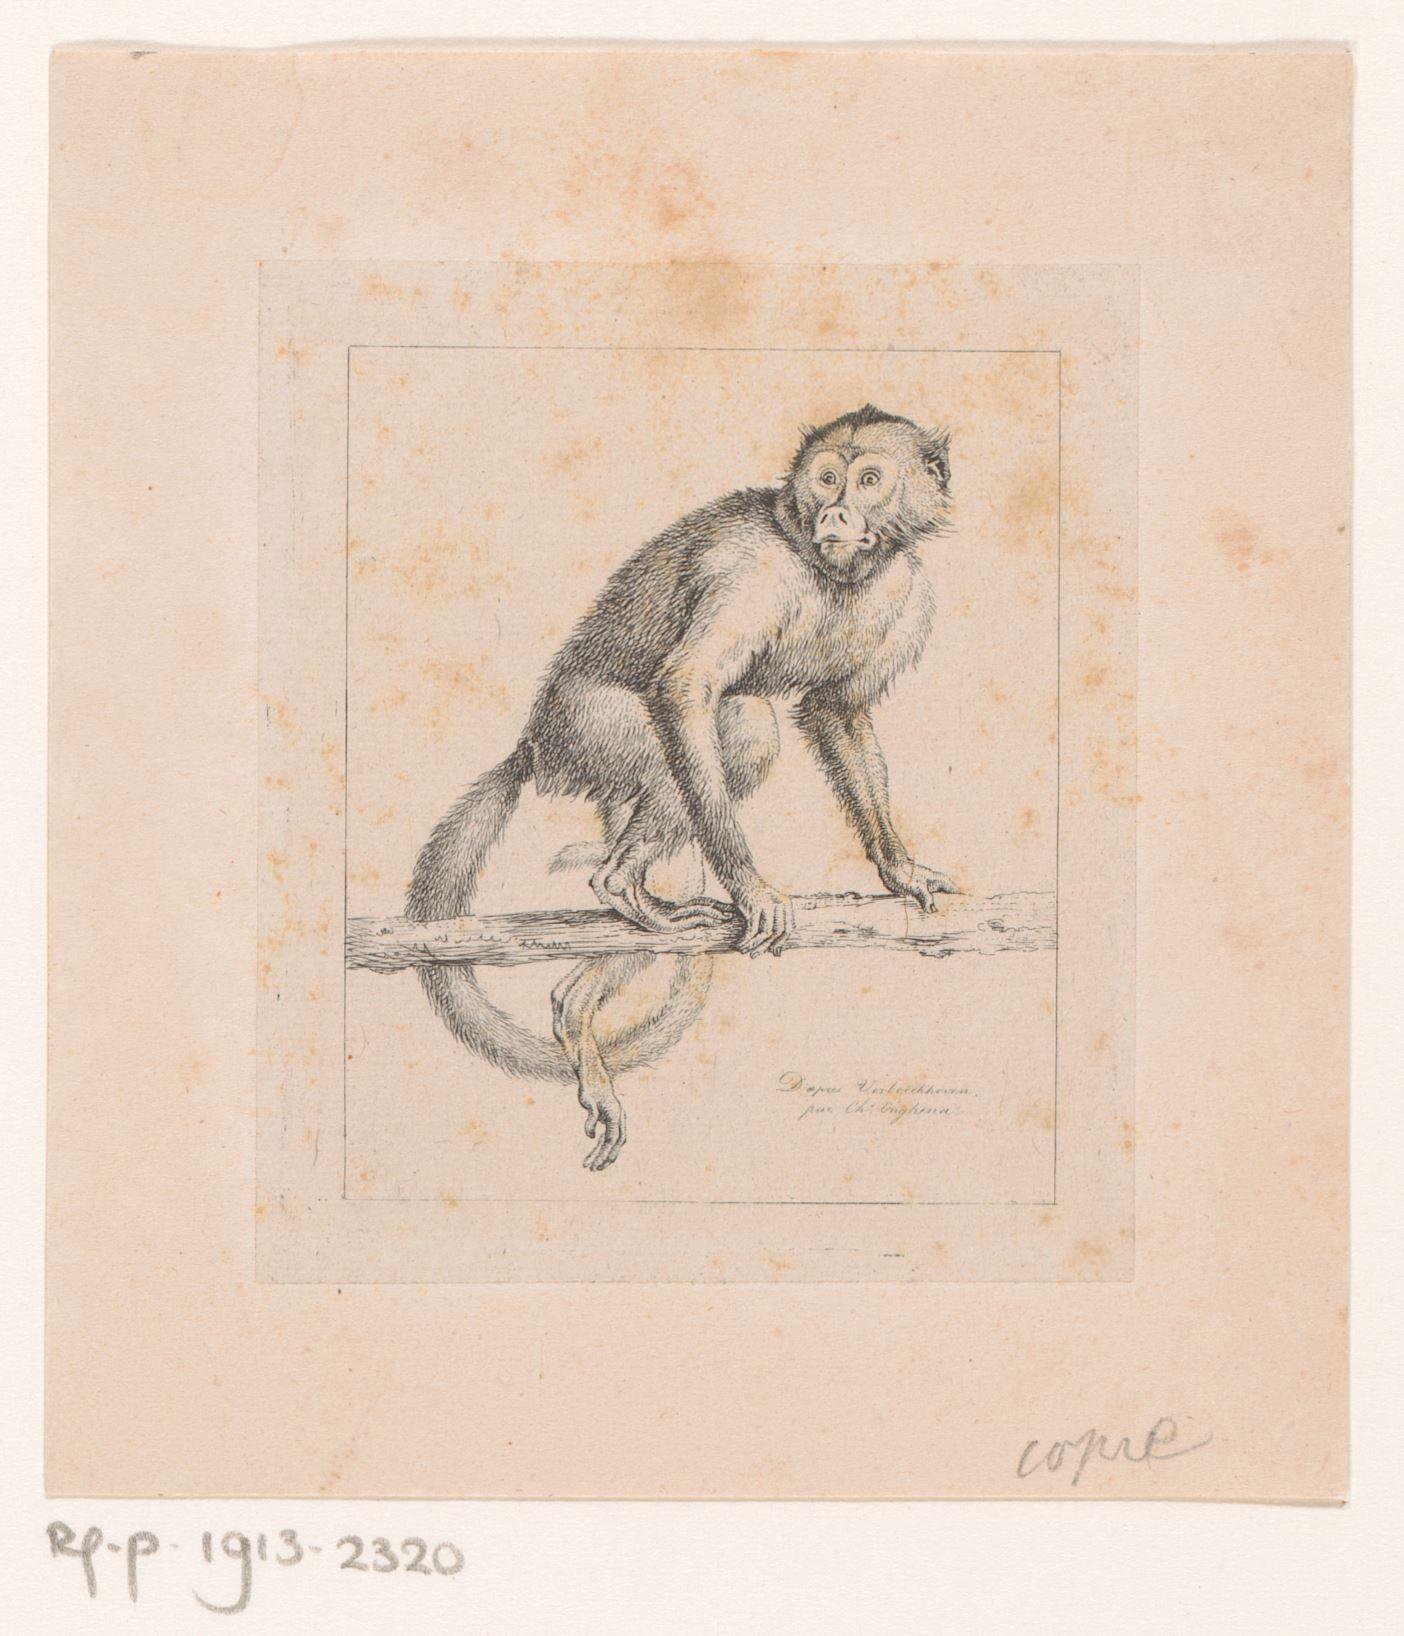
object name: print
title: Aap op een tak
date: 1816-1886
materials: paper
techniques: etching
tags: monkeys, apes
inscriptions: collector's mark: Lugt 1485, collector's mark: Lugt 2228